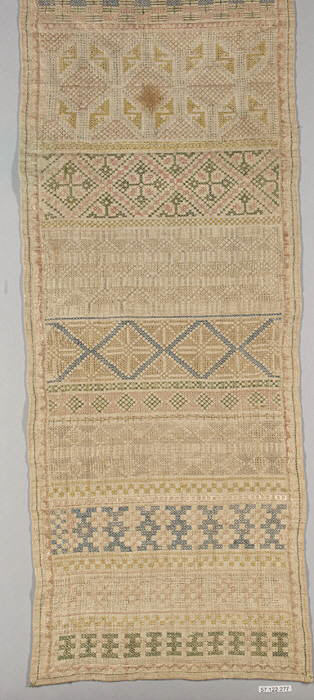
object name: sampler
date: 1833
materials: linen, silk